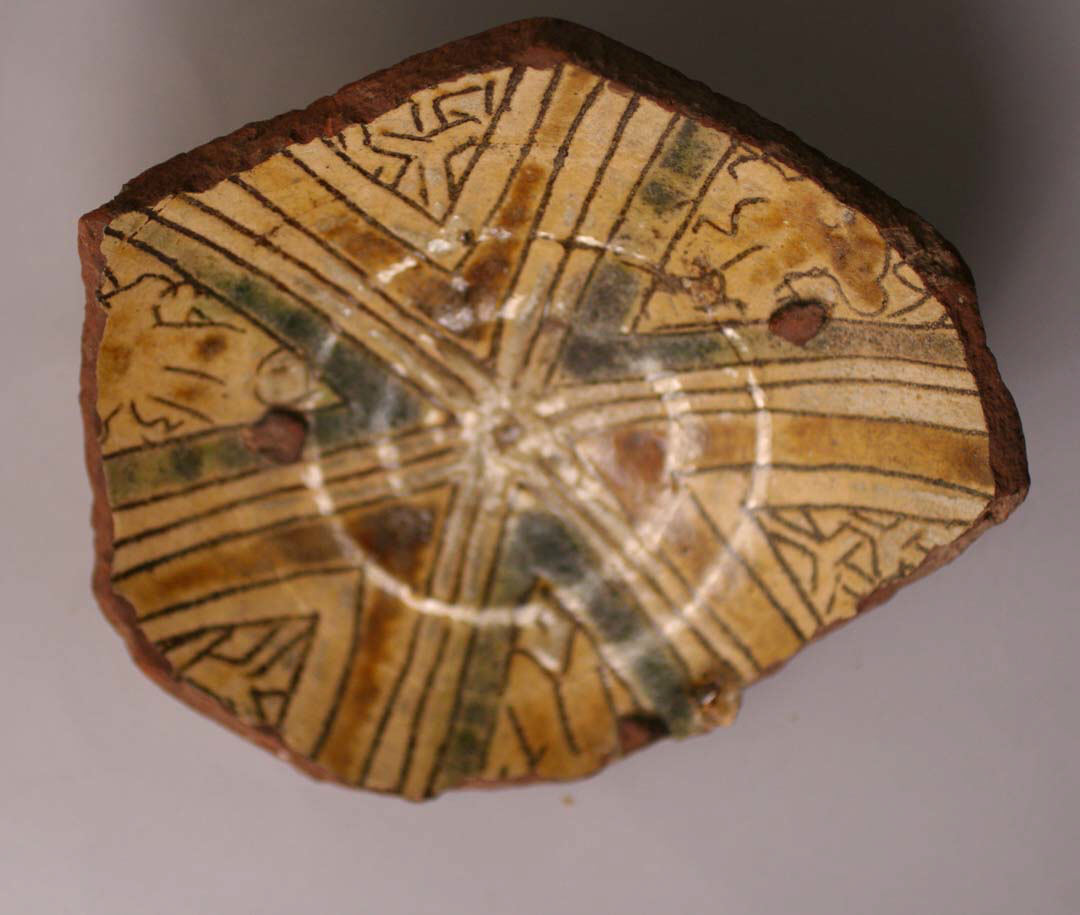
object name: fragment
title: Fragment of a Bowl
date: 1301-1500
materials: earthenware, glaze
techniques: coloring, incising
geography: egypt